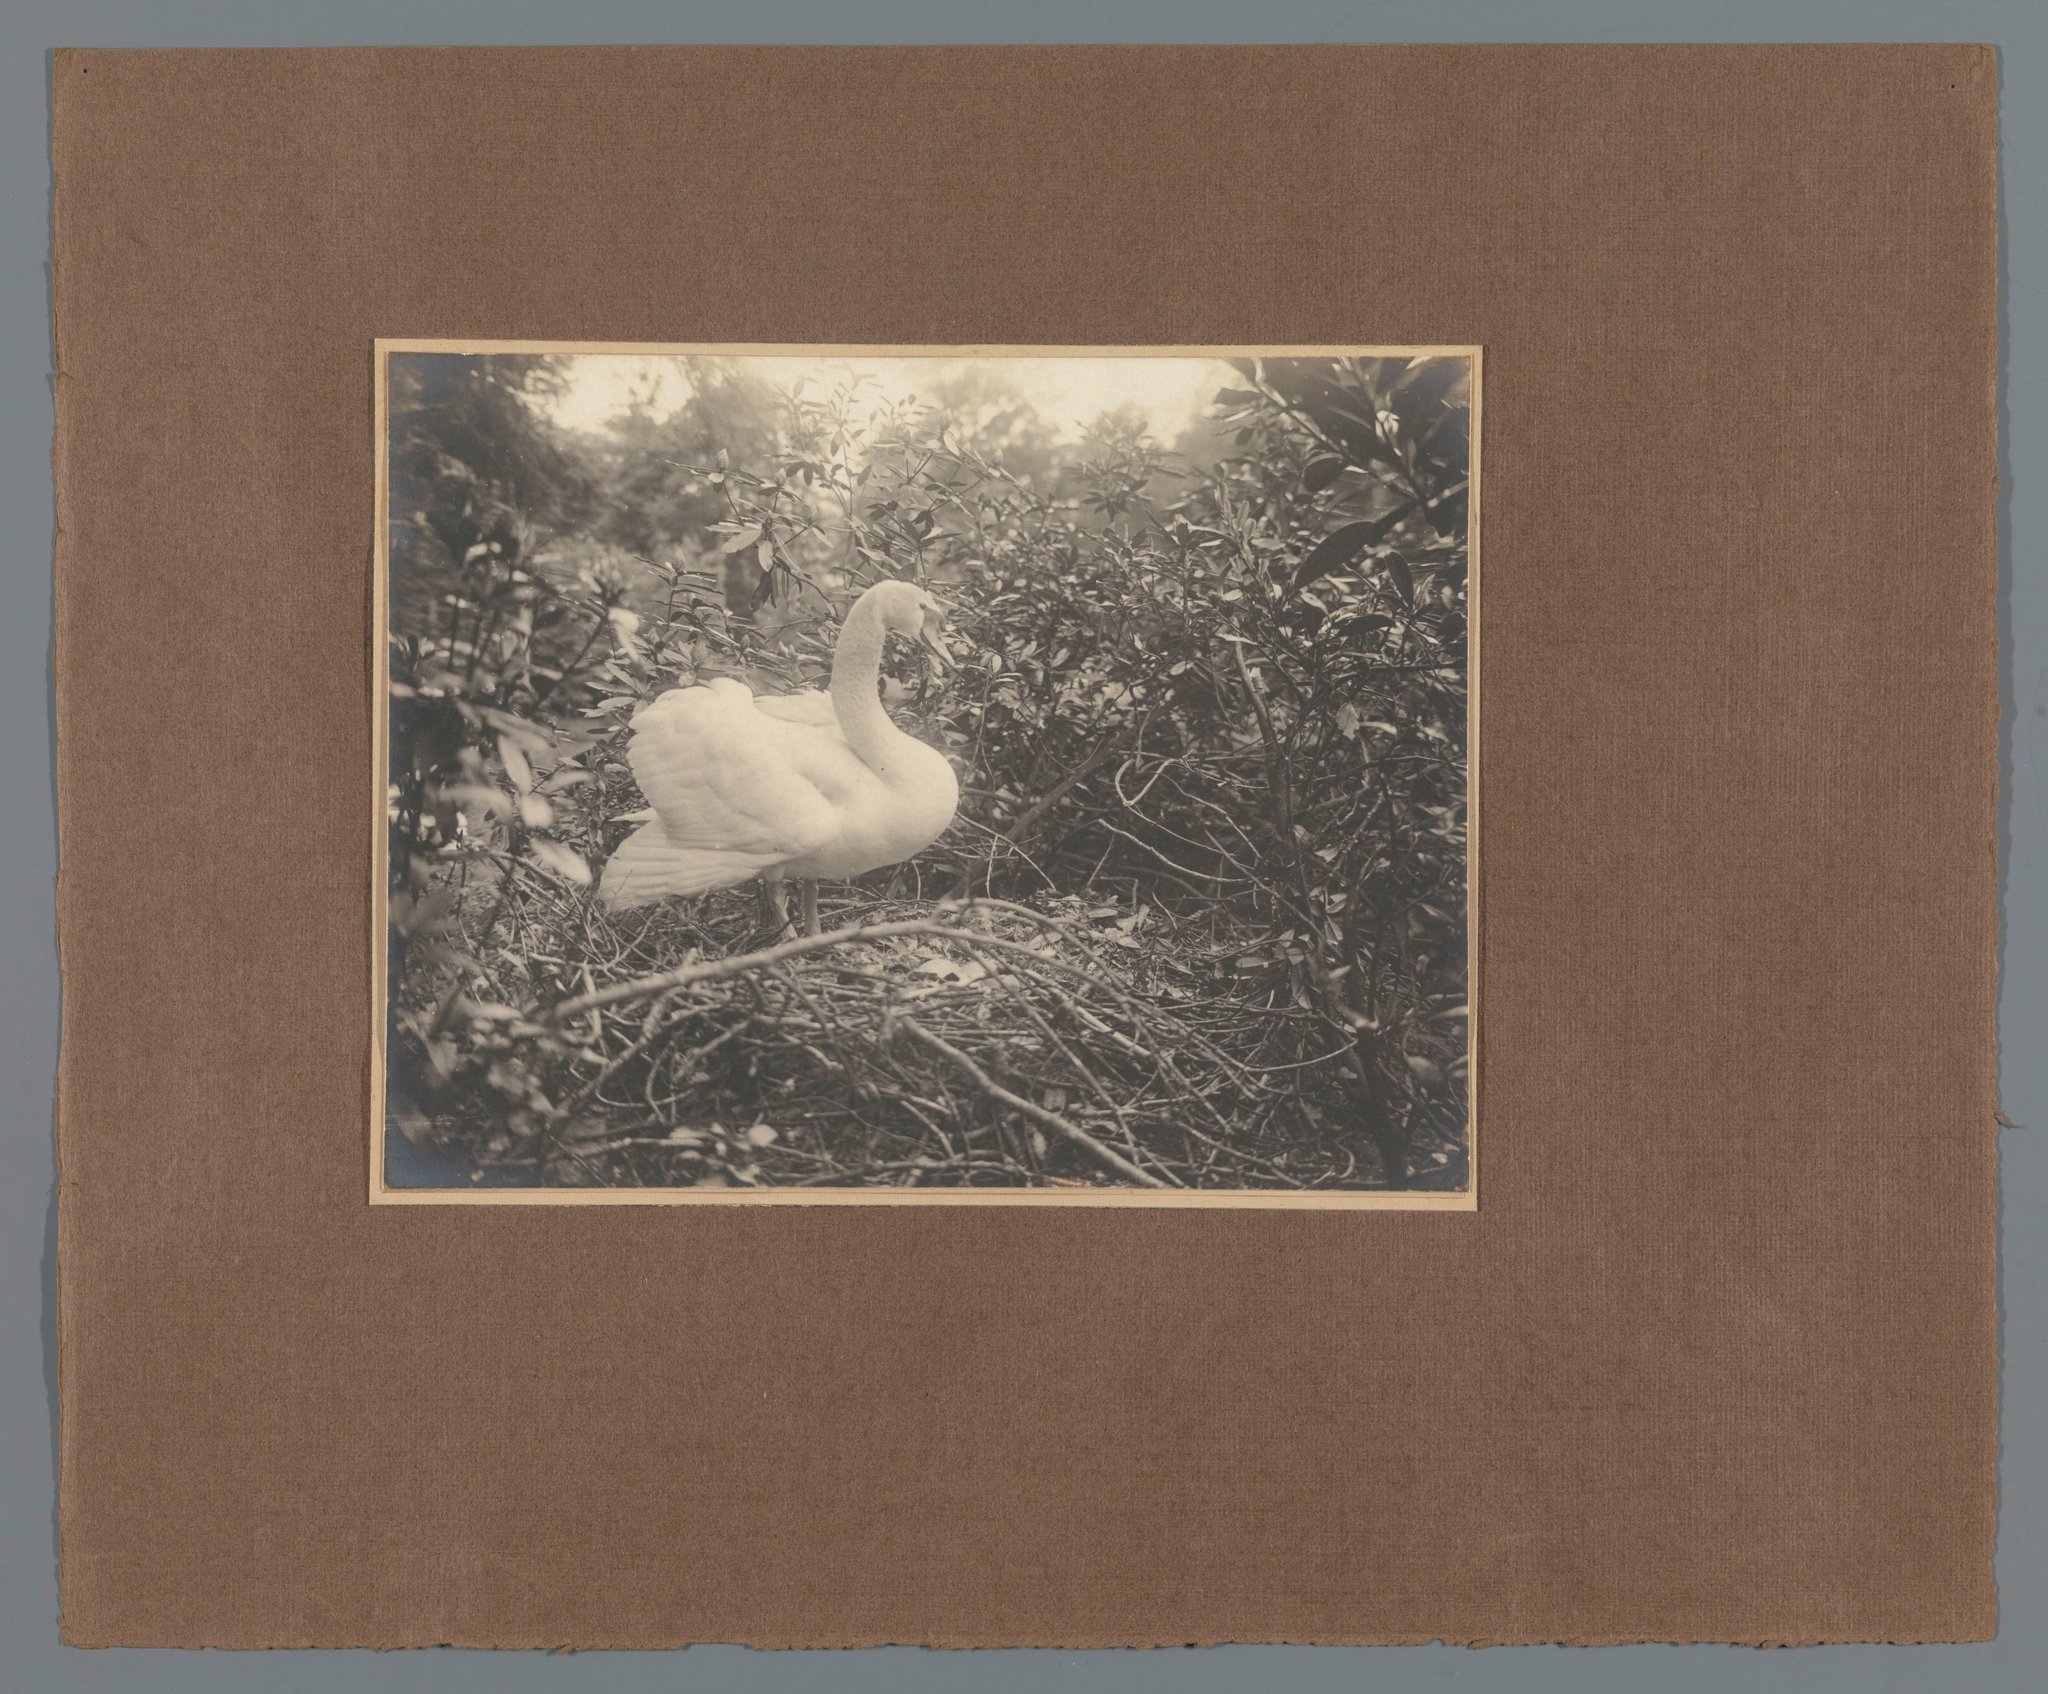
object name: photograph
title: Zwaan op het nest (vogels, nesten)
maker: richard tepe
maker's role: fotograaf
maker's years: 1864-1952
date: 1900-1930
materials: paper, photographic support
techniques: gelatin silver print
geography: netherlands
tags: water-birds: swan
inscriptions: number: ‘612’, annotation: ‘Keanwort [?] Natur / 12 Bilder / Gruppe A. und B. / 8 Schwan am Nest’, number: ‘11-66’